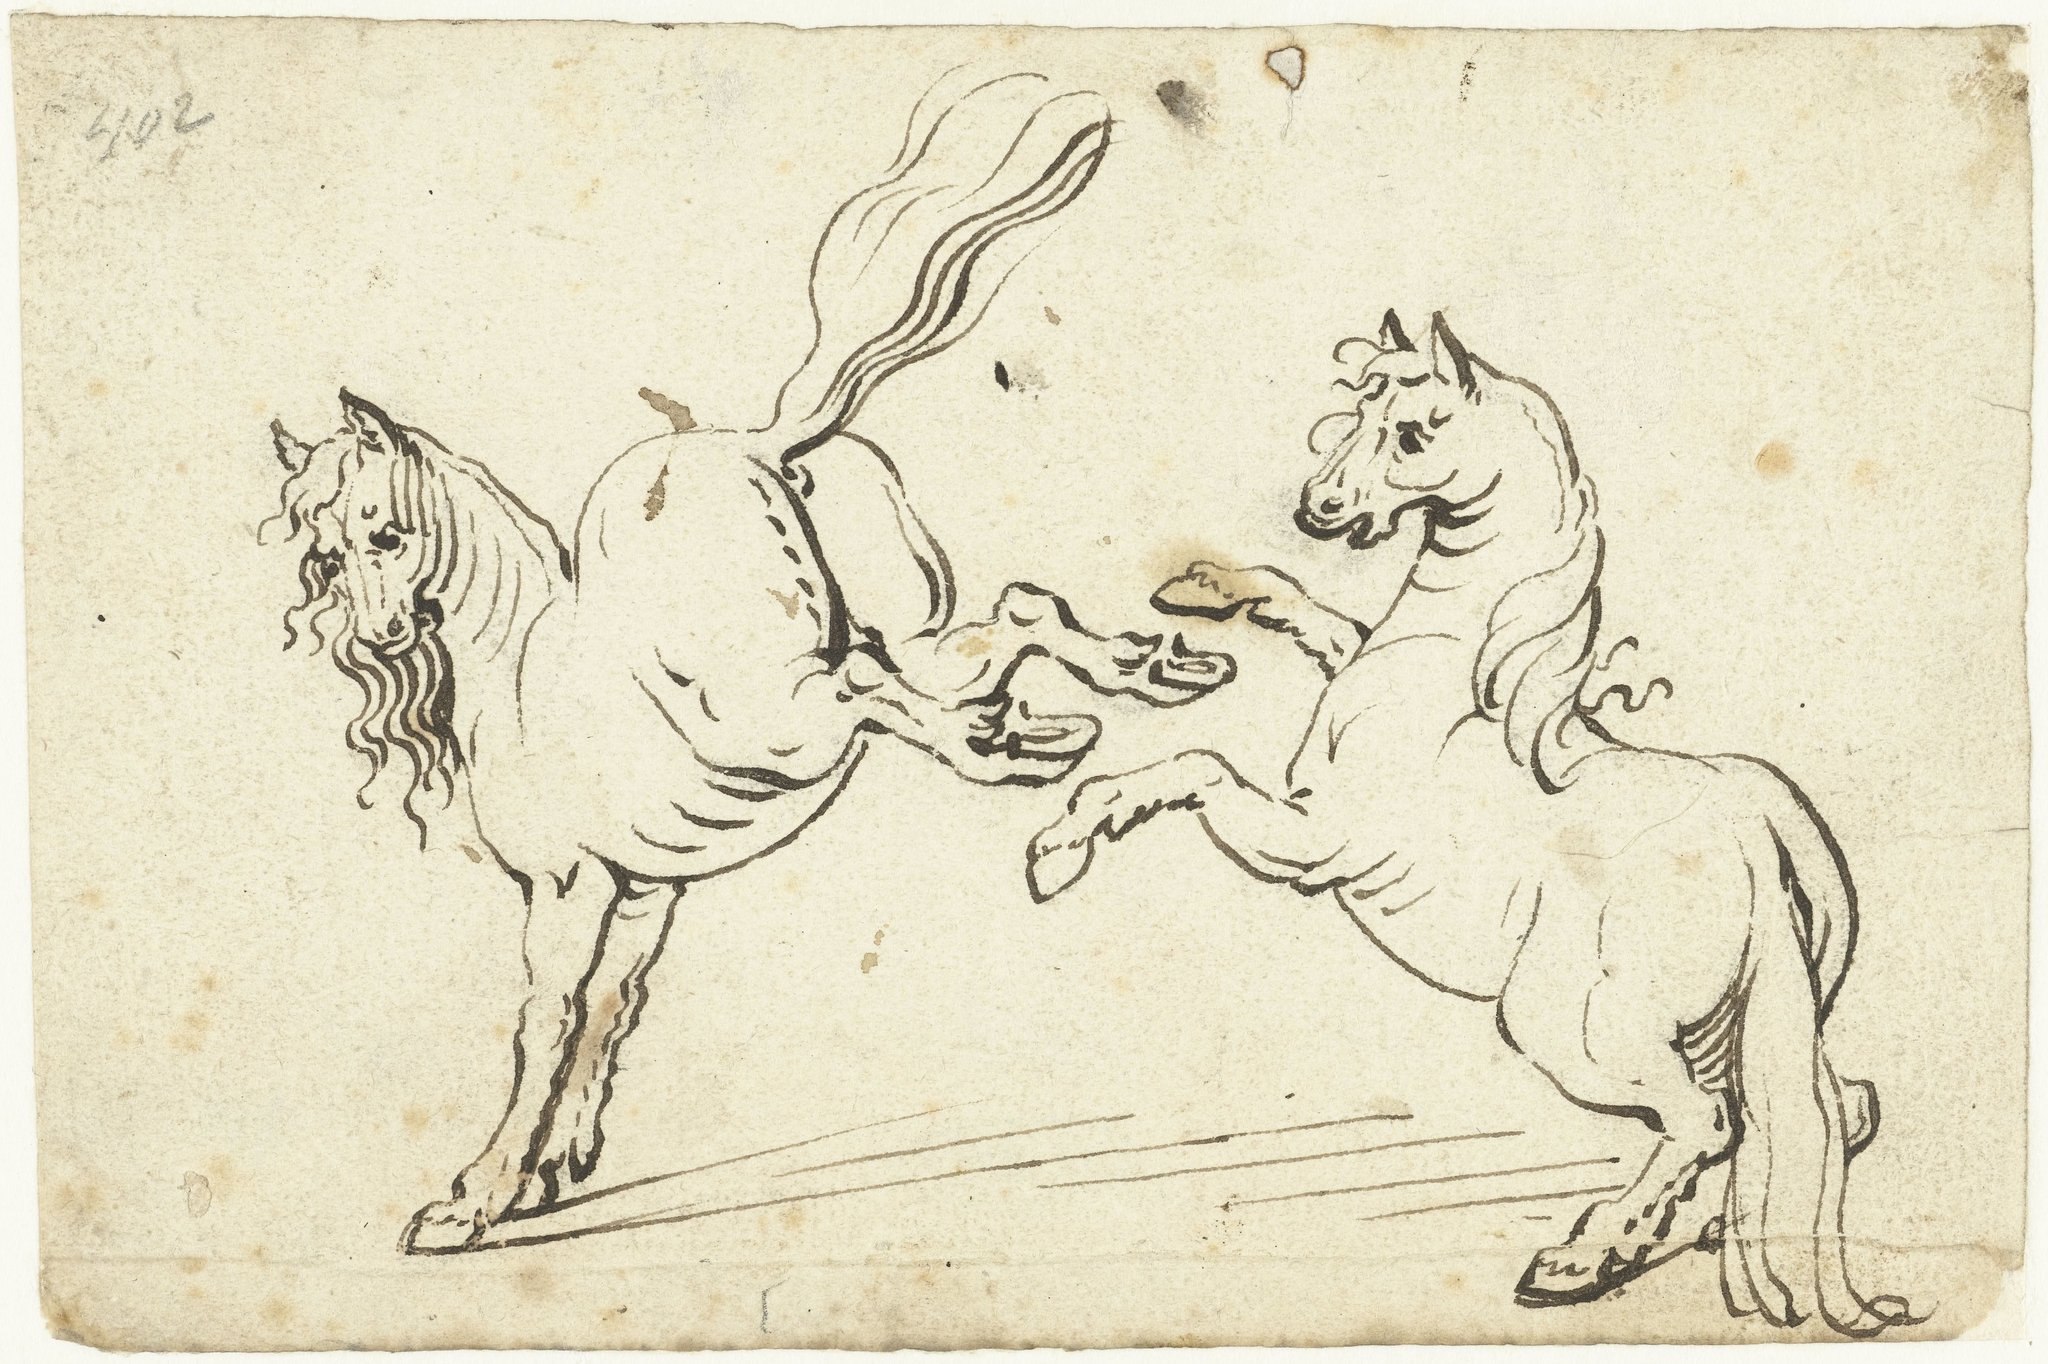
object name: drawing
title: Steigerend en een galopperend paard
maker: gerard ter borch (i)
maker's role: draughtsman, print maker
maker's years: 1584-1662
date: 1615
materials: ink, paper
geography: zwolle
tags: horses and kindred animals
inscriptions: number: ‘402’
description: Het rechterpaard is gebaseerd op een prent uit de serie Paarden in verschillende posities van Antonio Tempesta, in spiegelbeeld (vrij naar Antonio Tempesta, Bar. 879) serie nr. 16 (24); het linkerpaard lijkt een inventie te zijn van de kunstenaar.